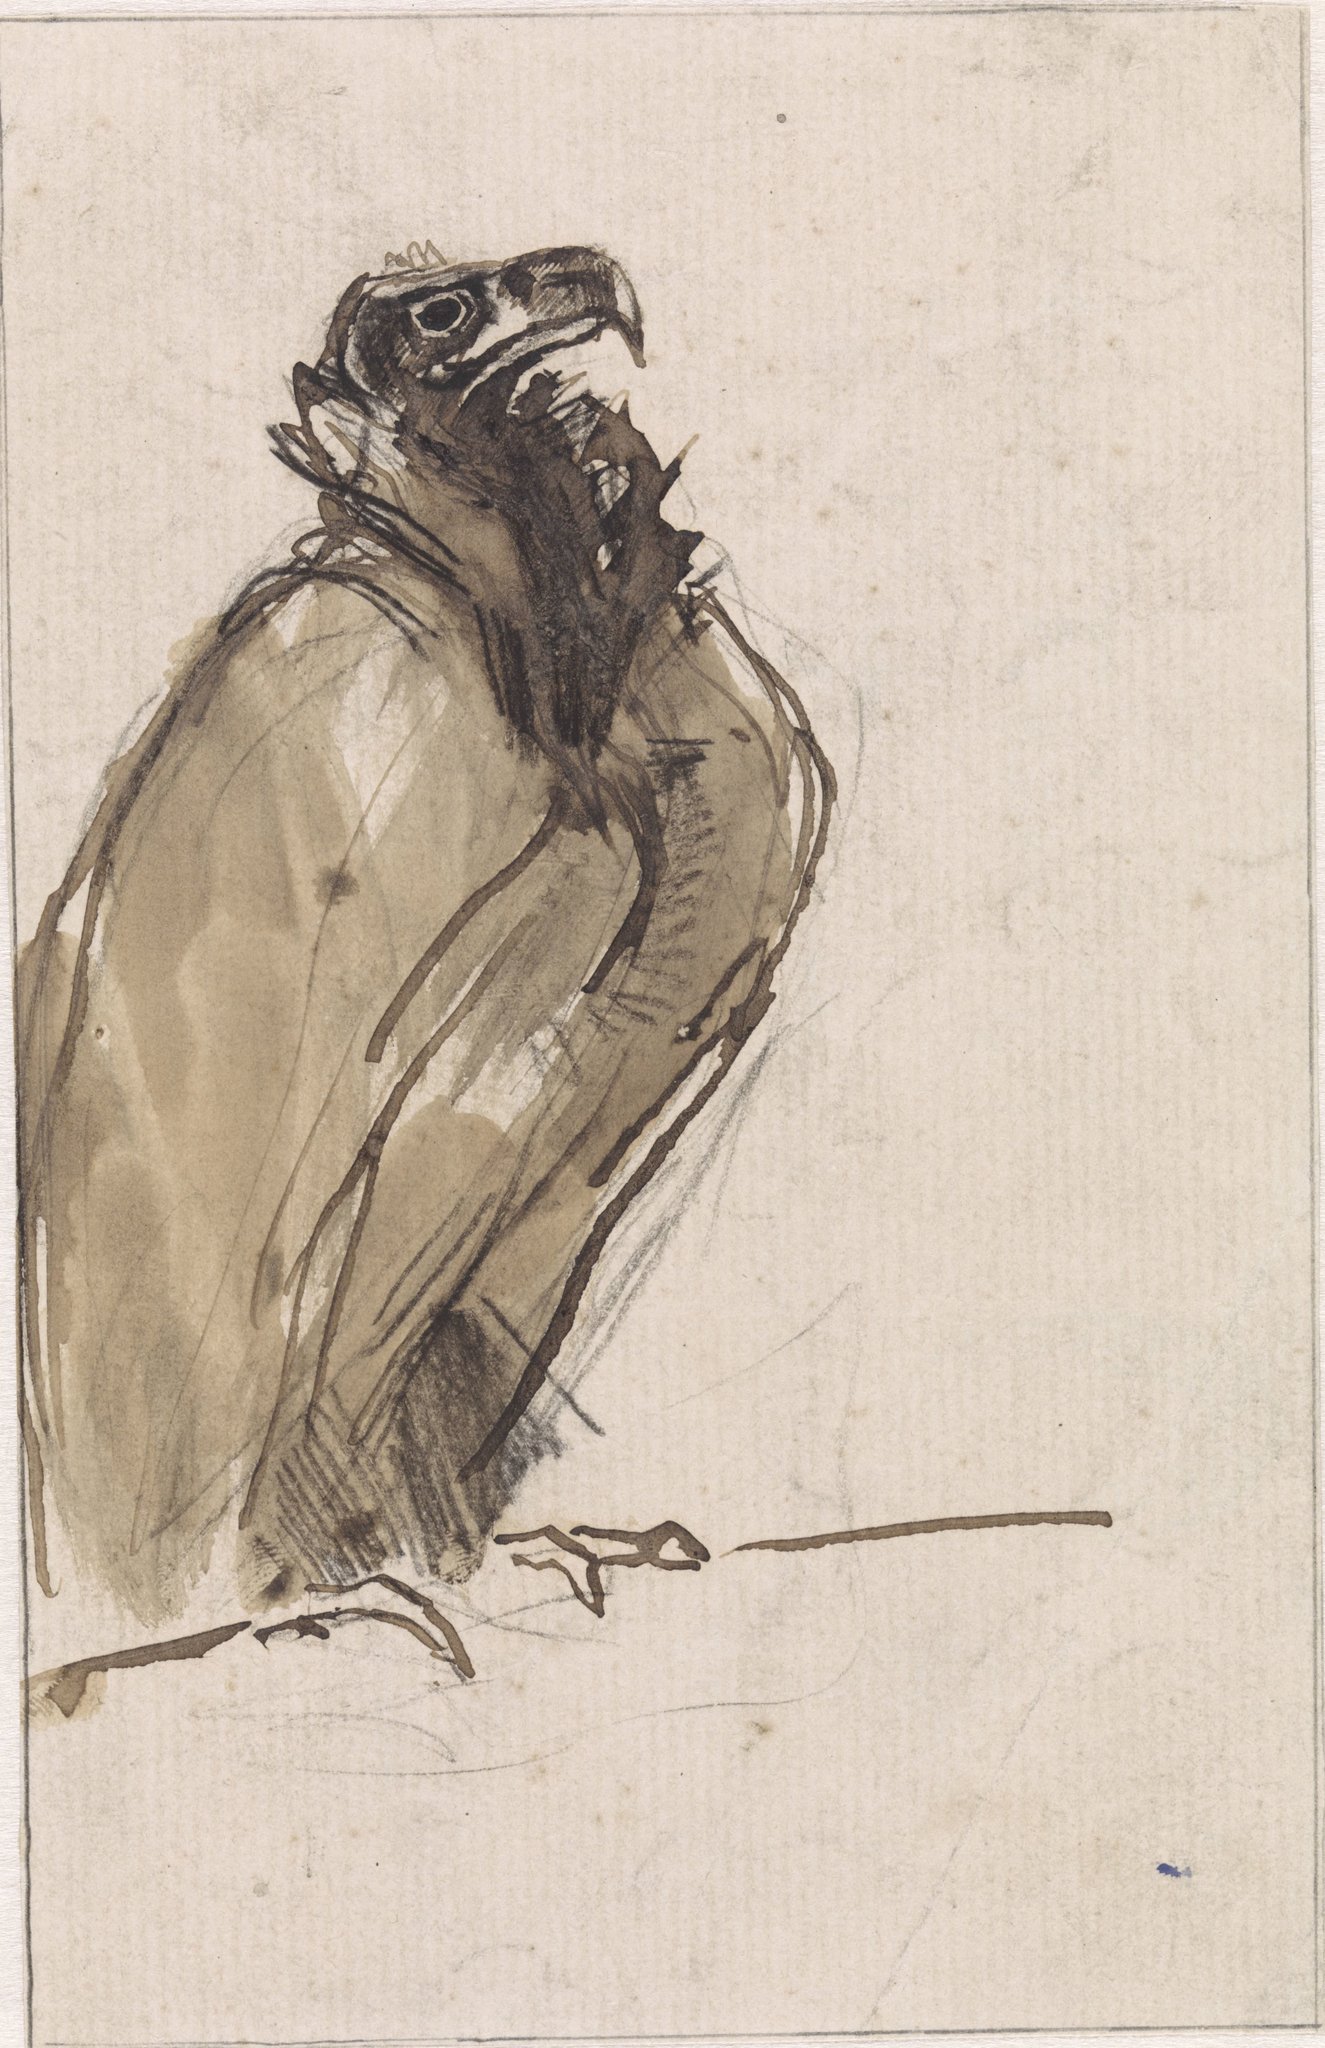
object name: drawing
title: Gier, zittend op een tak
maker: jan van essen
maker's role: draughtsman, print maker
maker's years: 1854-1936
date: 1864-1936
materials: chalk, ink, paper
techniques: brush, pen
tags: predatory birds: vulture